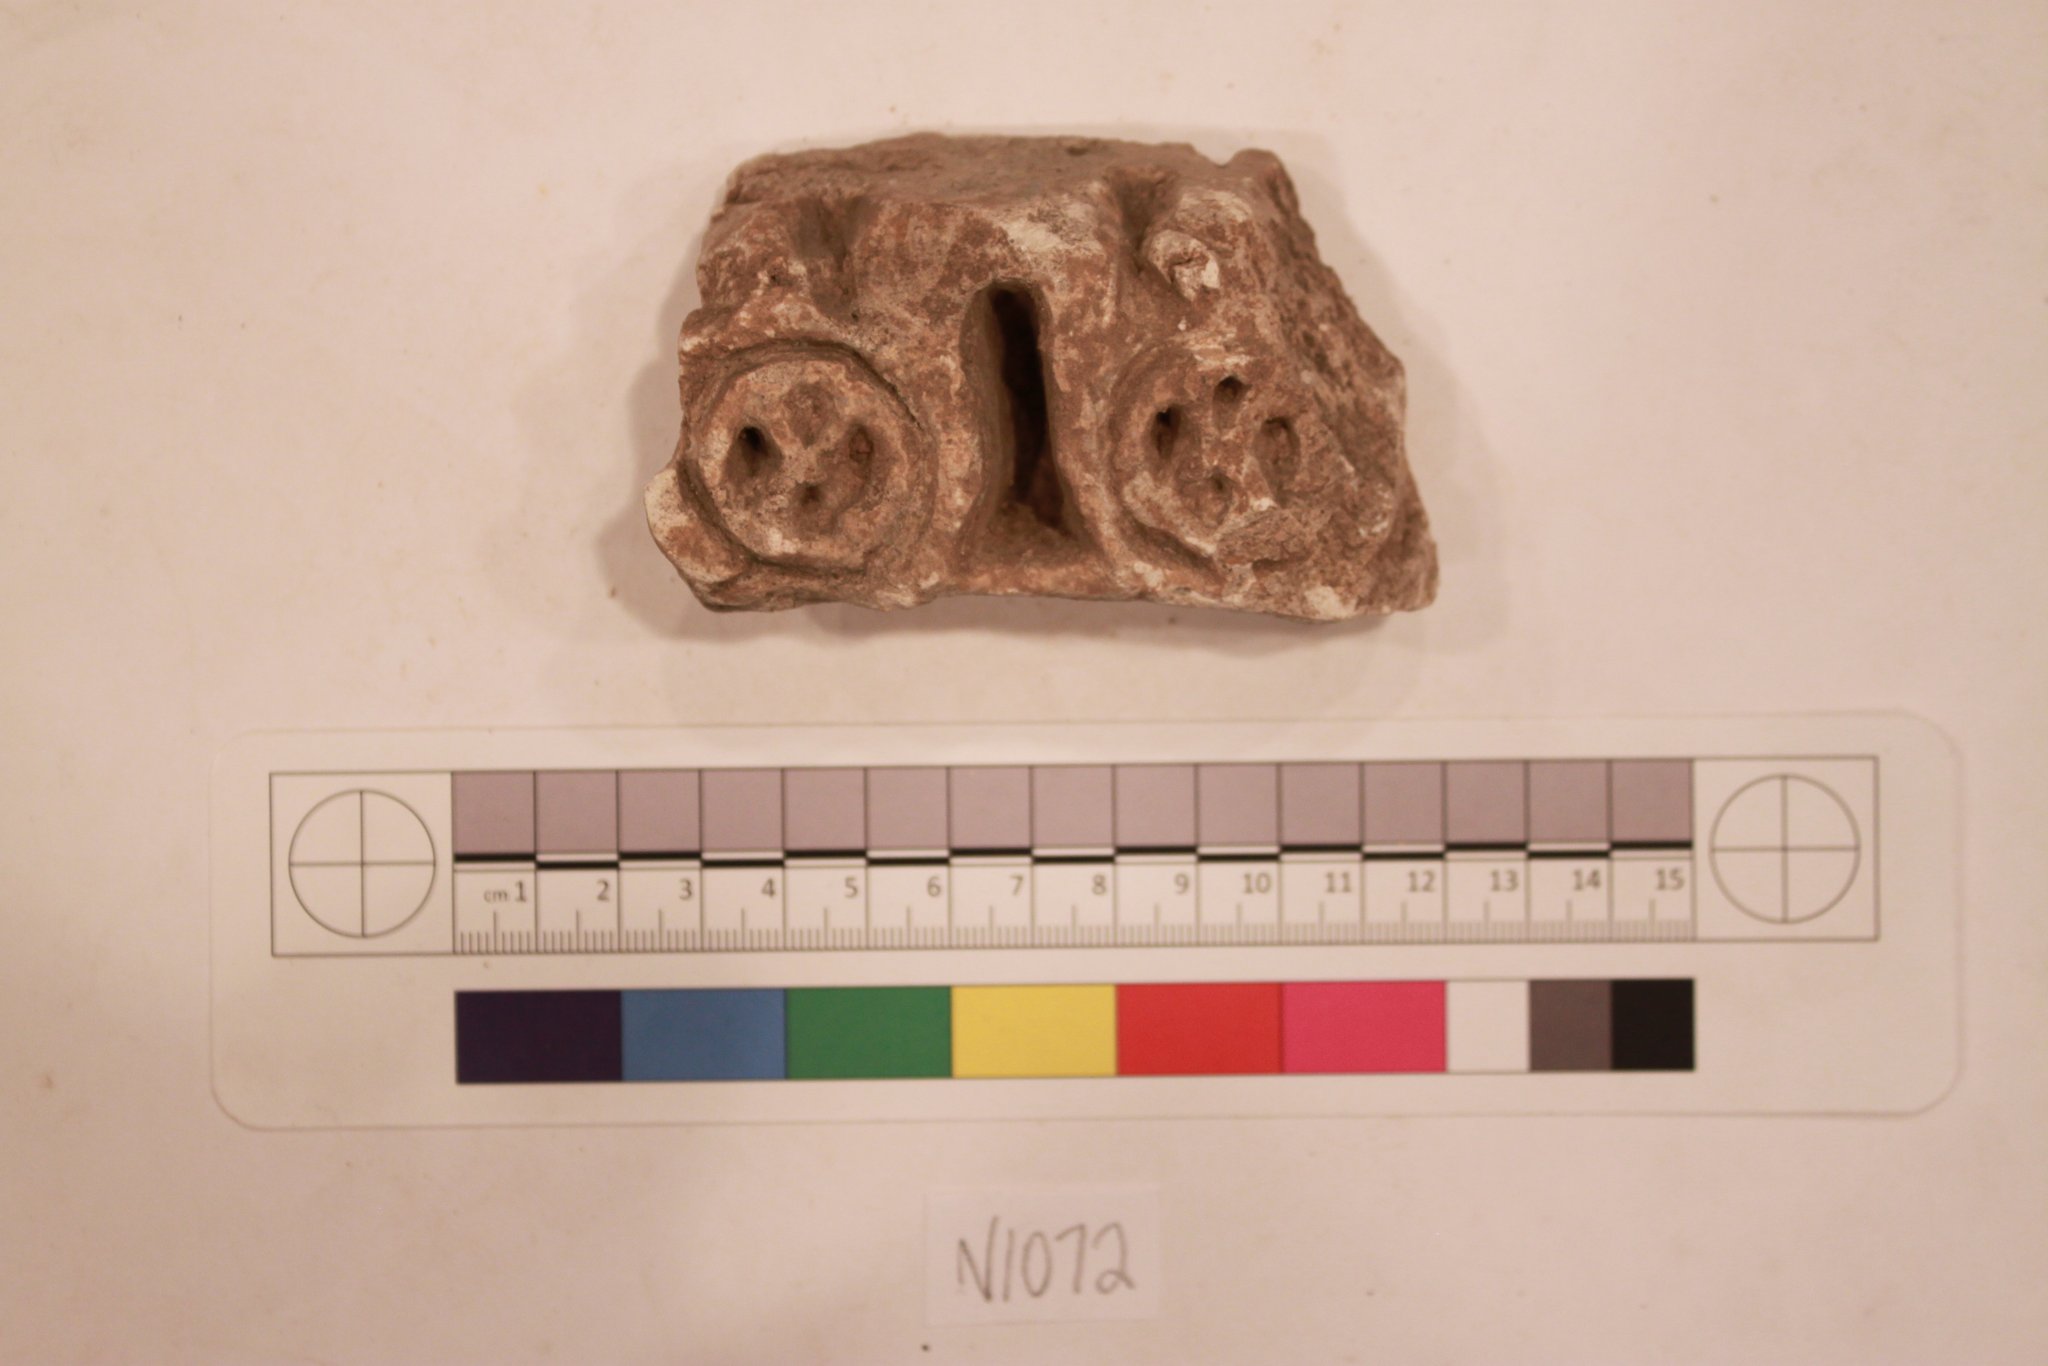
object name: fragment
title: Stucco Fragment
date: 701-1200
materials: plaster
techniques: carving, painting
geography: iran